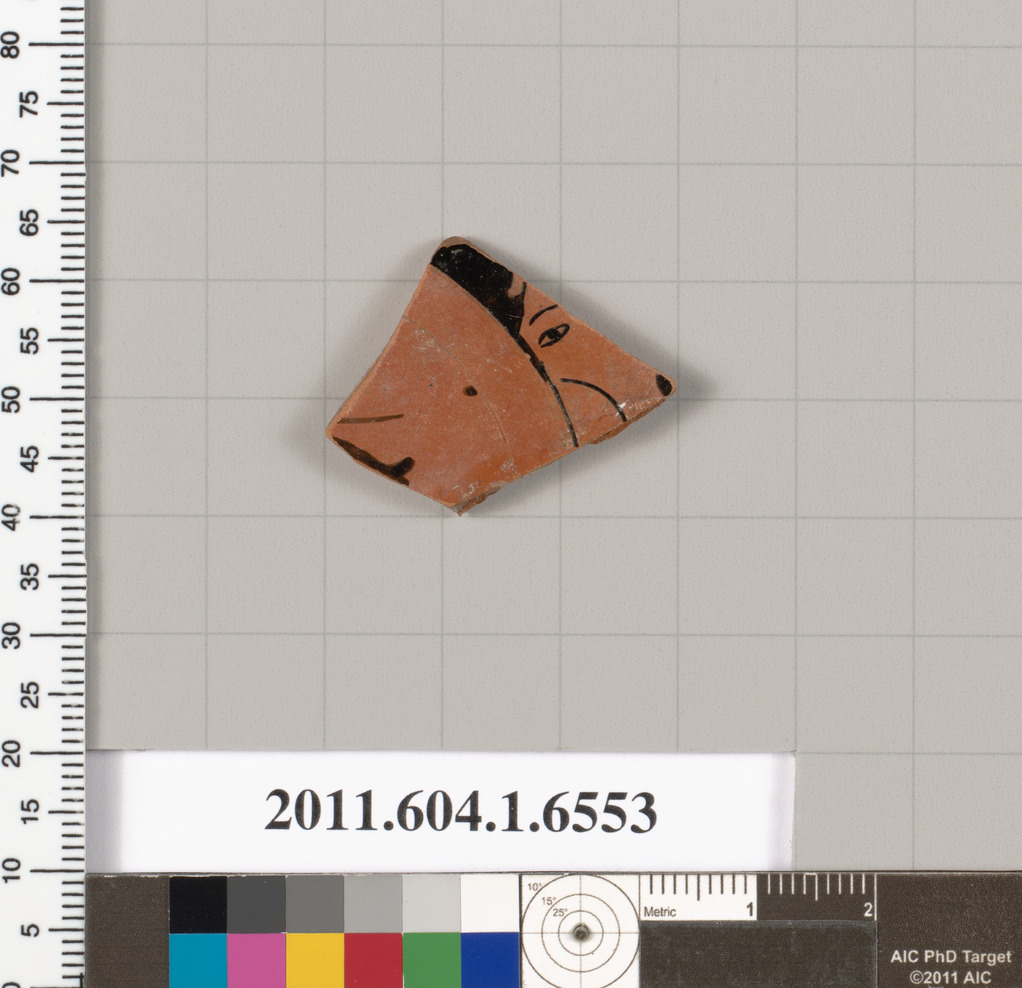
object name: kylix fragment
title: Terracotta fragment of a kylix (drinking cup)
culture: greek, attic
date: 490-480 BCE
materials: terracotta